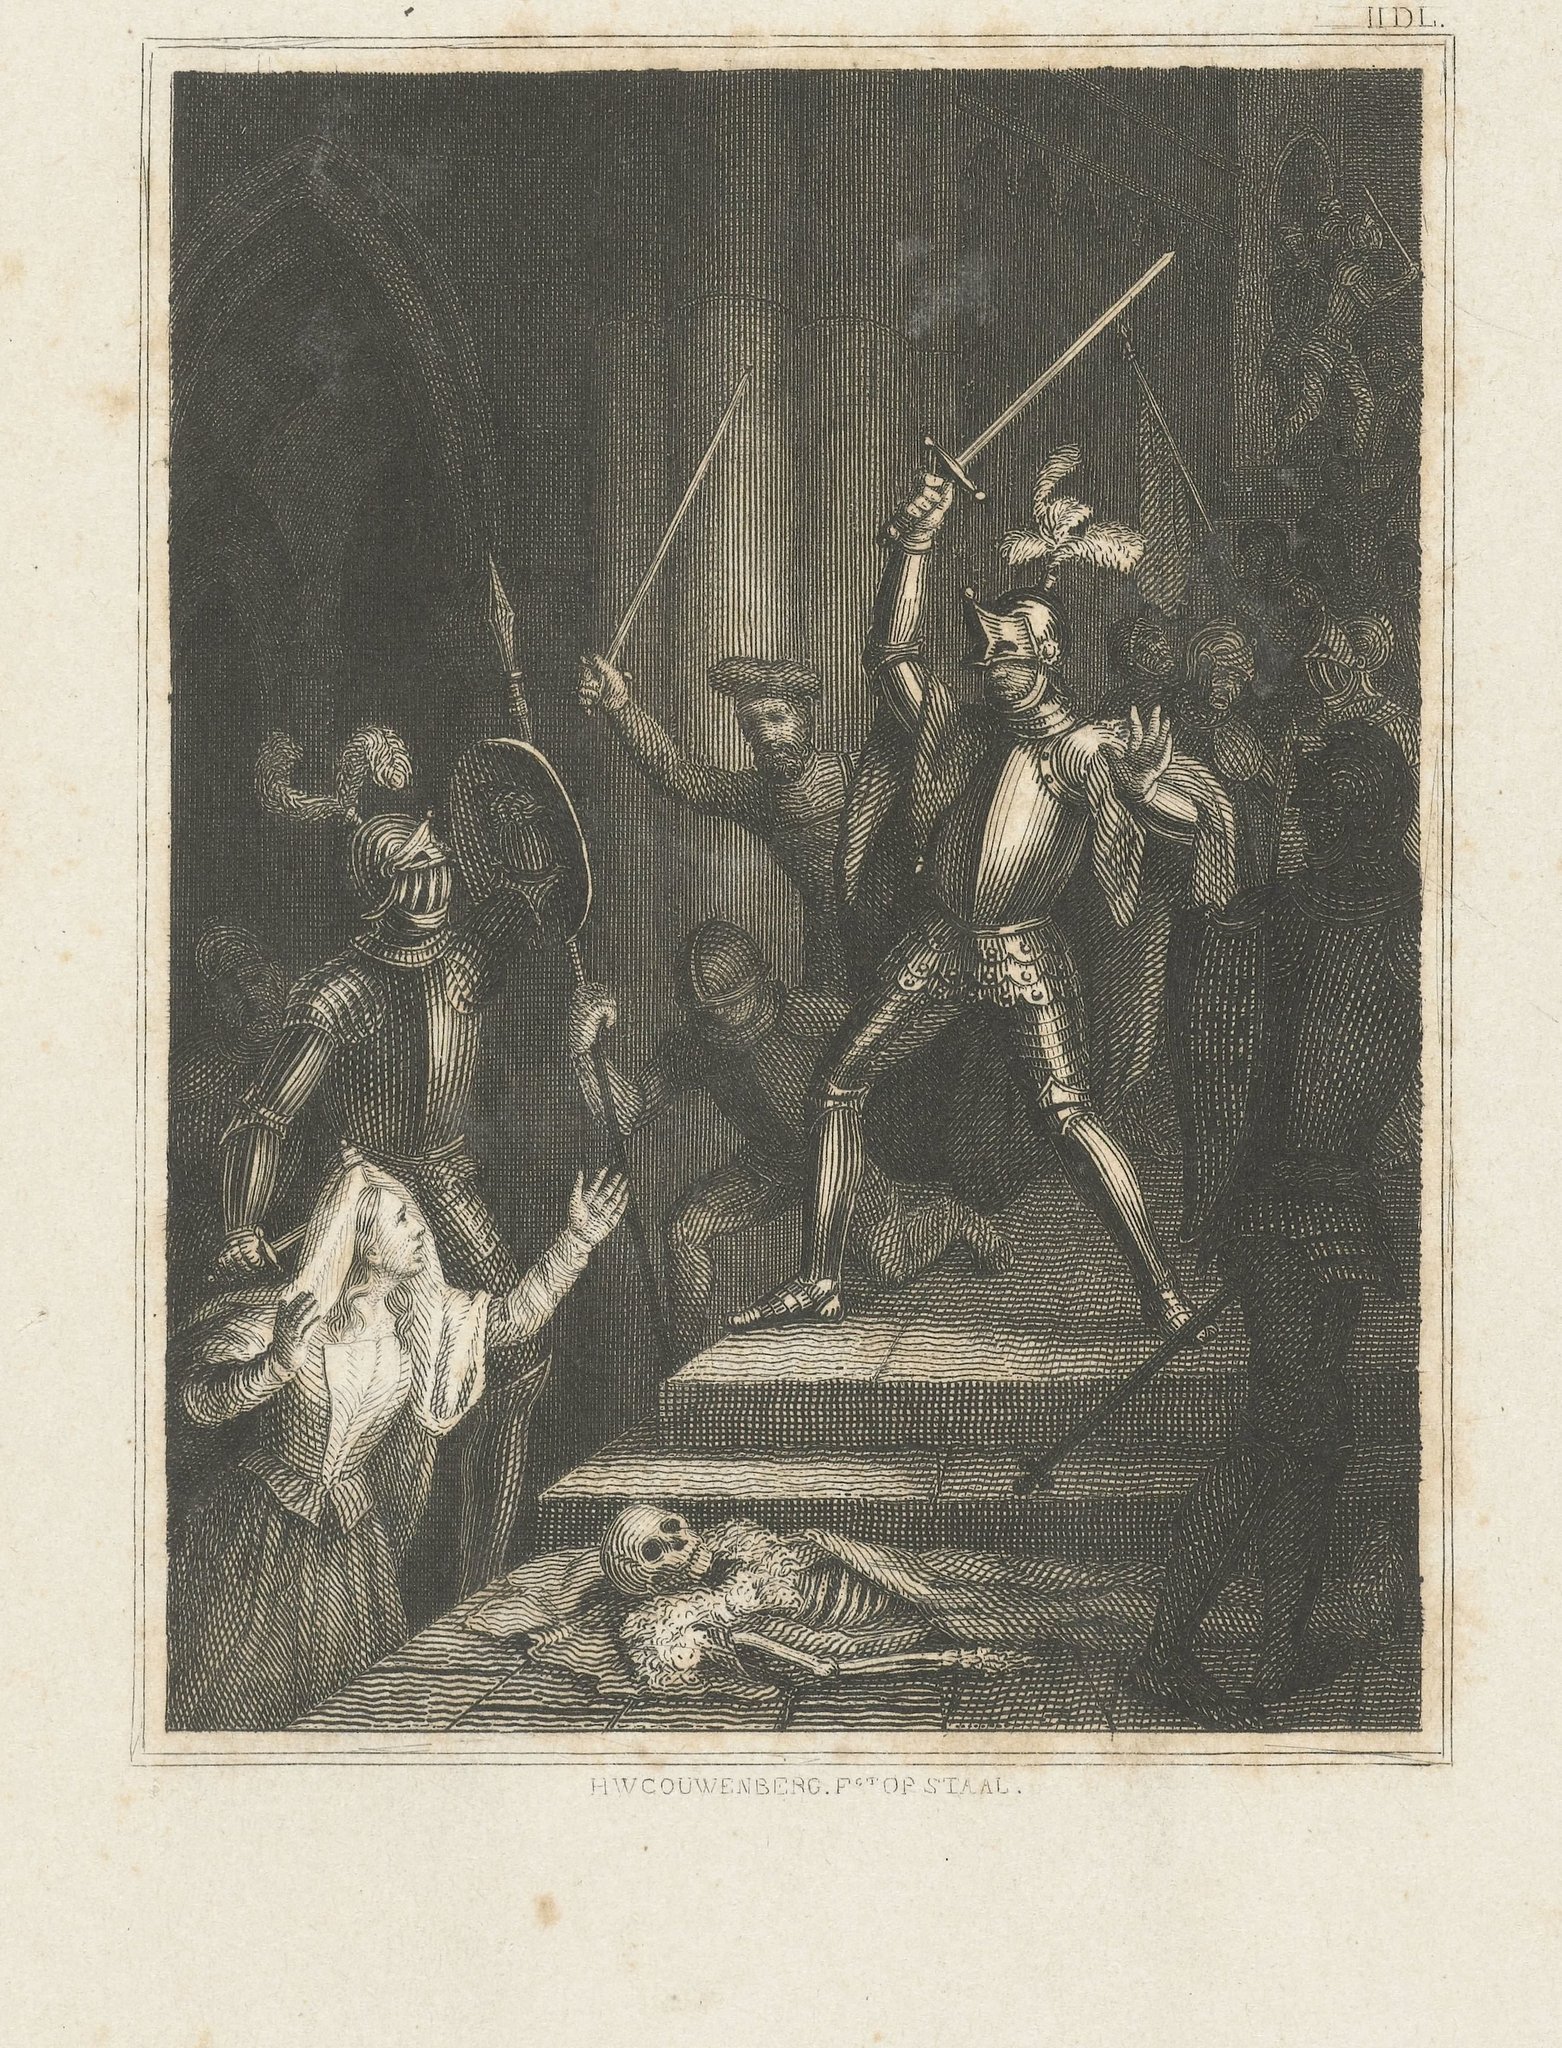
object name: print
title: Ridders vechten in de grafkelder van een kerk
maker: henricus wilhelmus couwenberg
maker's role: draughtsman, print maker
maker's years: 1814-1845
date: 1830-1845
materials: paper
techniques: engraving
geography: amsterdam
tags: (human) skeleton, knight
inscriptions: collector's mark: Lugt 2228